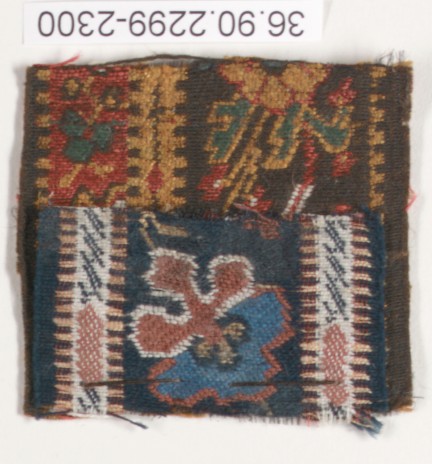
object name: border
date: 1801-1900